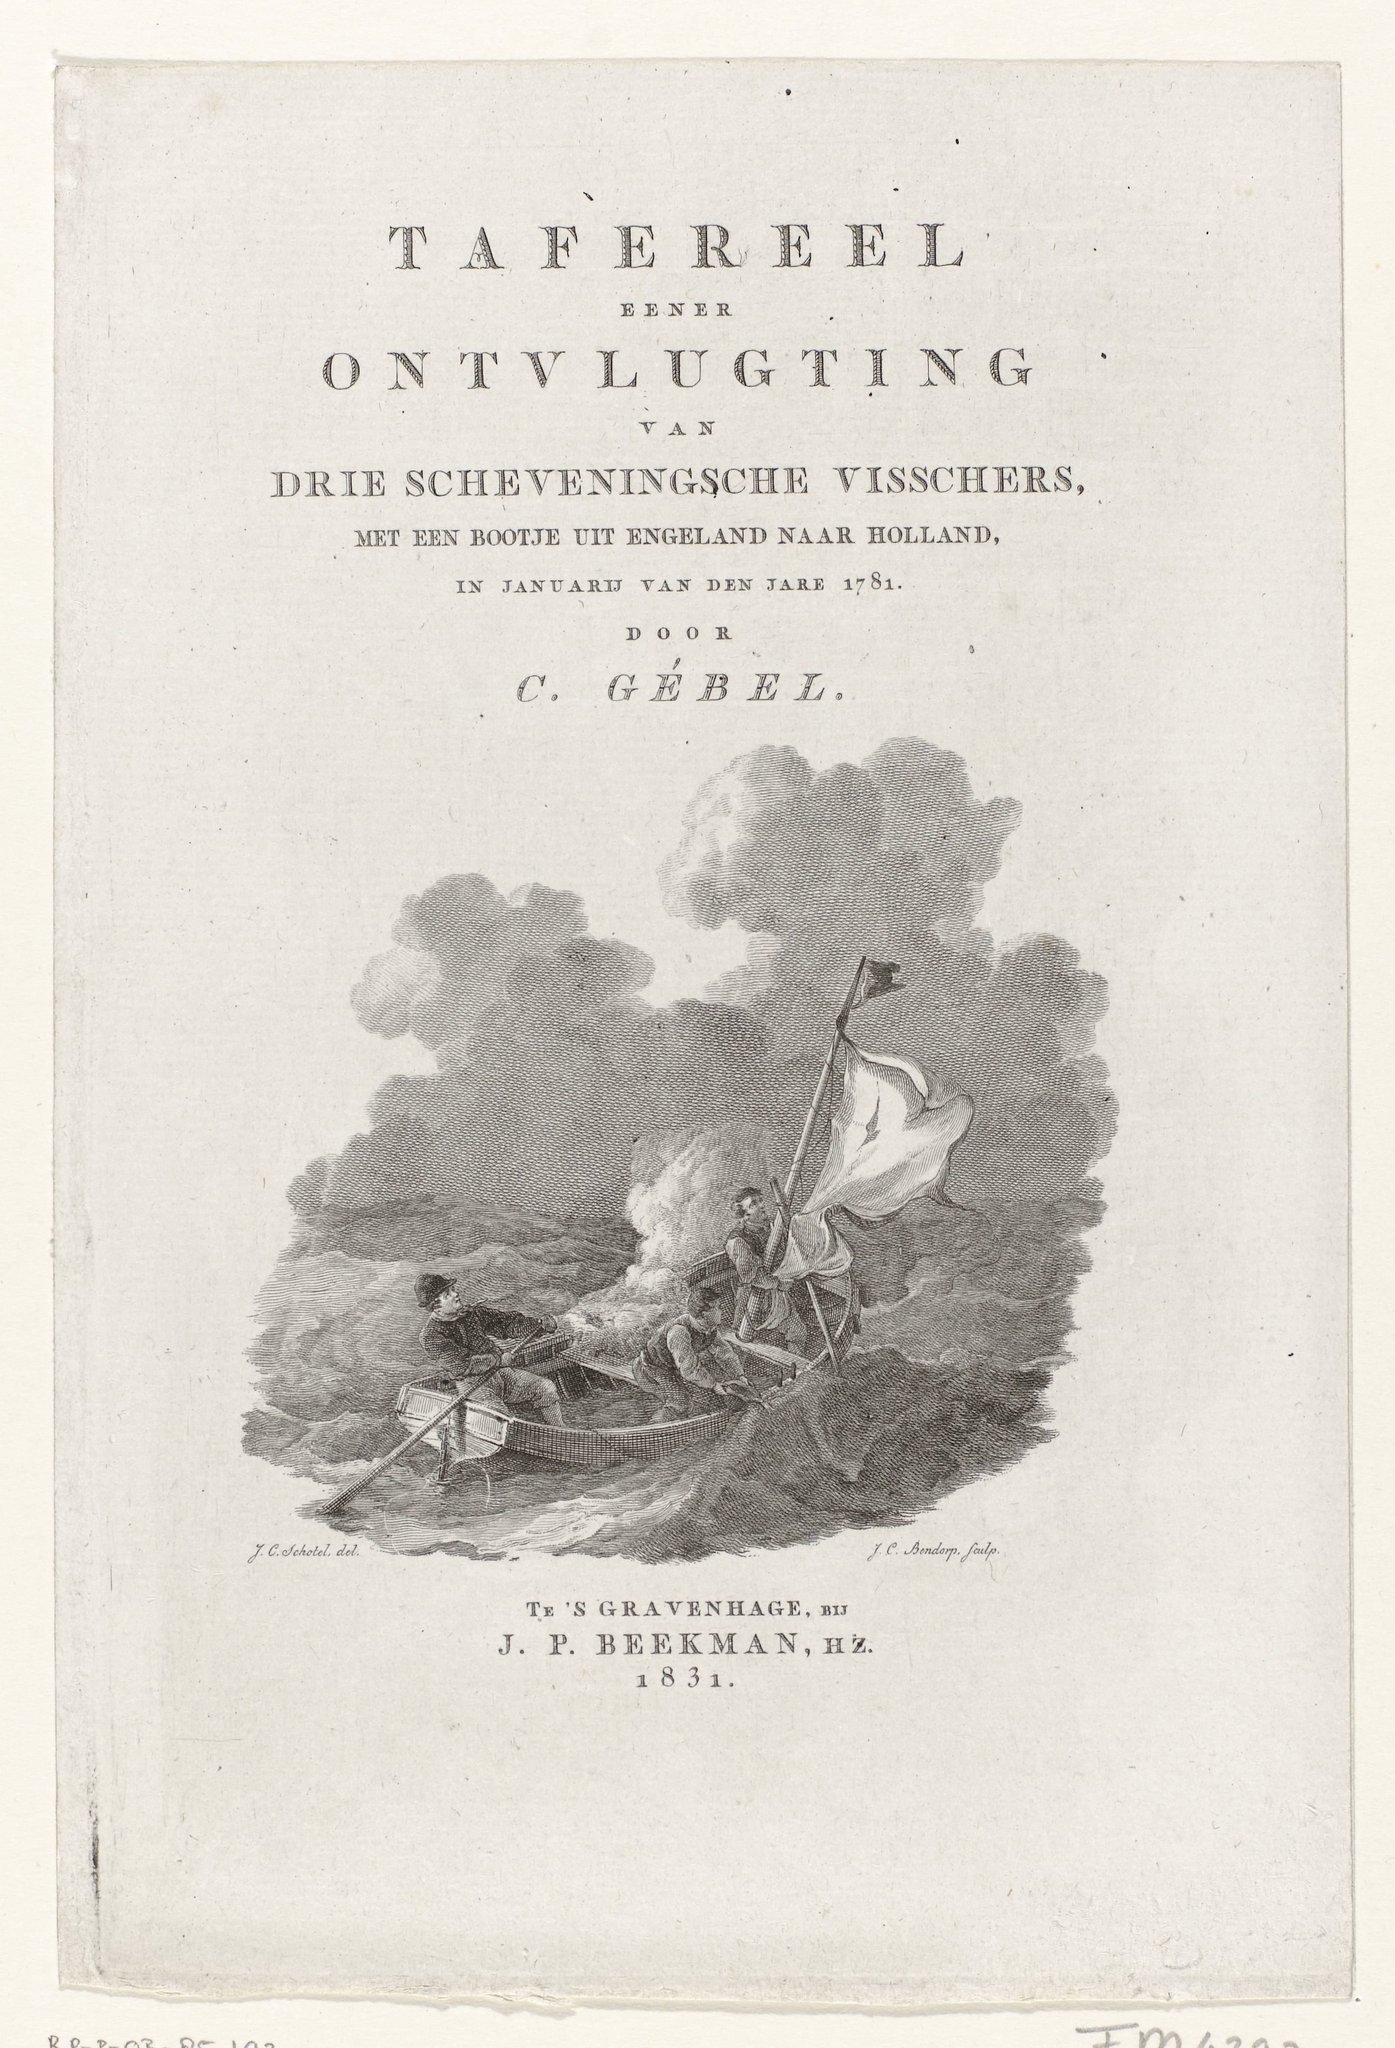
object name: titelblad, titelpagina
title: Titelpagina van: Tafereel eener Ontvlugting van Drie Scheveningsche Visschers, met een bootje uit Engeland naar Holland, in januarij van den jare 1781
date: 1831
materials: paper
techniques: engraving, etching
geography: the hague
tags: escape, escape attempts, rowing-boat, canoe, etc., fourth anglo-dutch war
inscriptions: collector's mark: Lugt 2228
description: Gebruikt als titelpagina van: Cornelis Gebel, Tafereel eener ontvlugting van drie Scheveningsche visschers, met een bootje uit Engeland naar Holland, in januarij van den jare 1781. 's-Gravenhage: J.P. Beekman Hz., 1831.